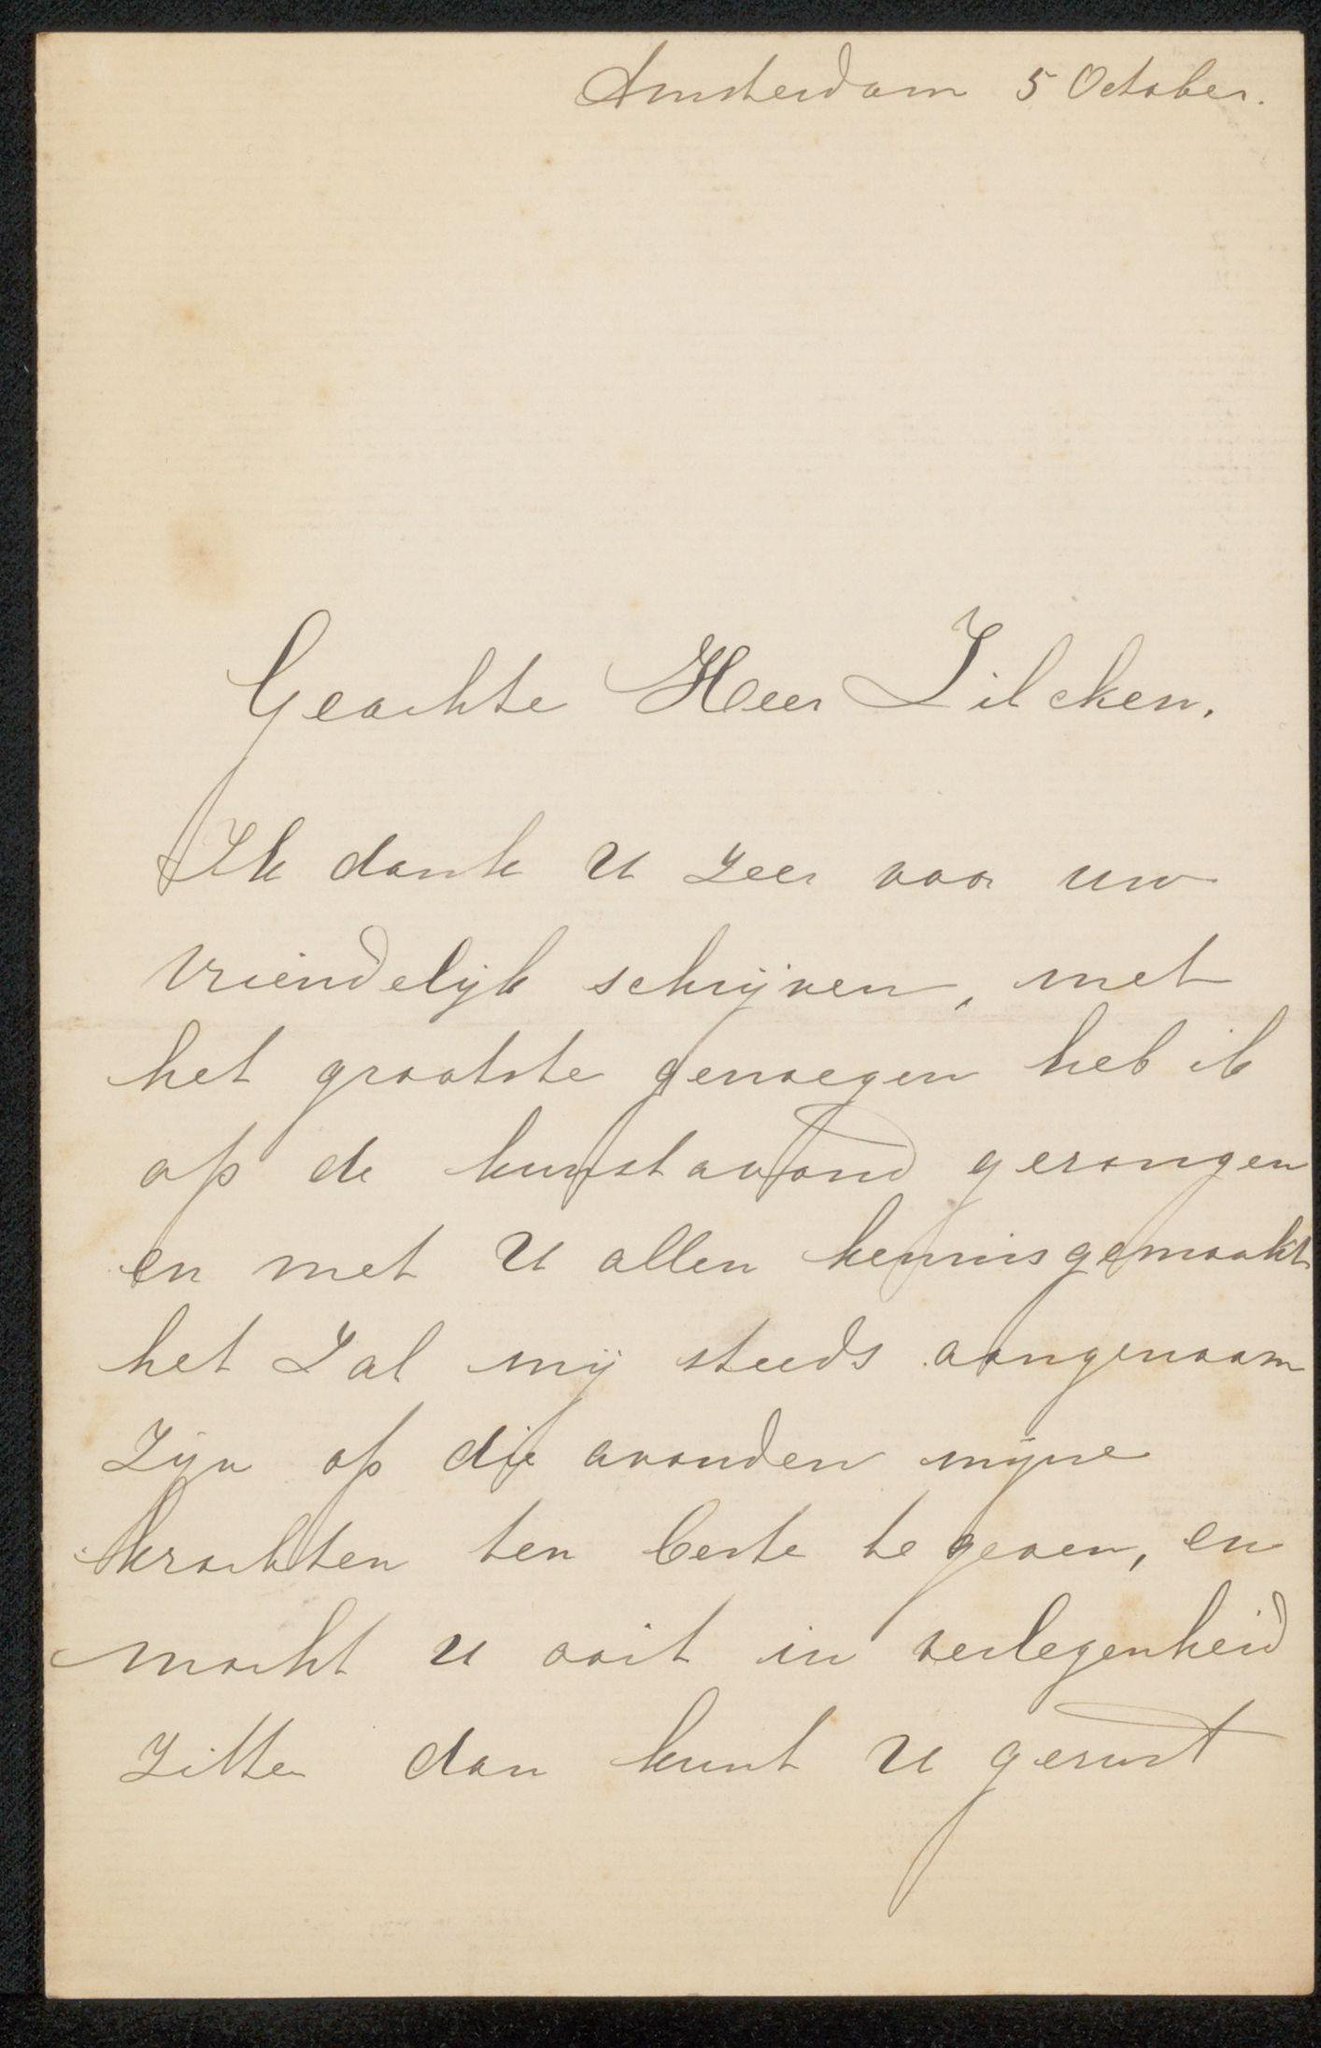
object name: letter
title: Brief aan Philip Zilcken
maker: jo kempées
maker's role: zangeres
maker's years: -1897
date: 1867-1897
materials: ink, paper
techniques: pen, writing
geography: amsterdam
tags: the hague, painter, draughtsman, philip zilcken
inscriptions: collector's mark: ‘RPK’